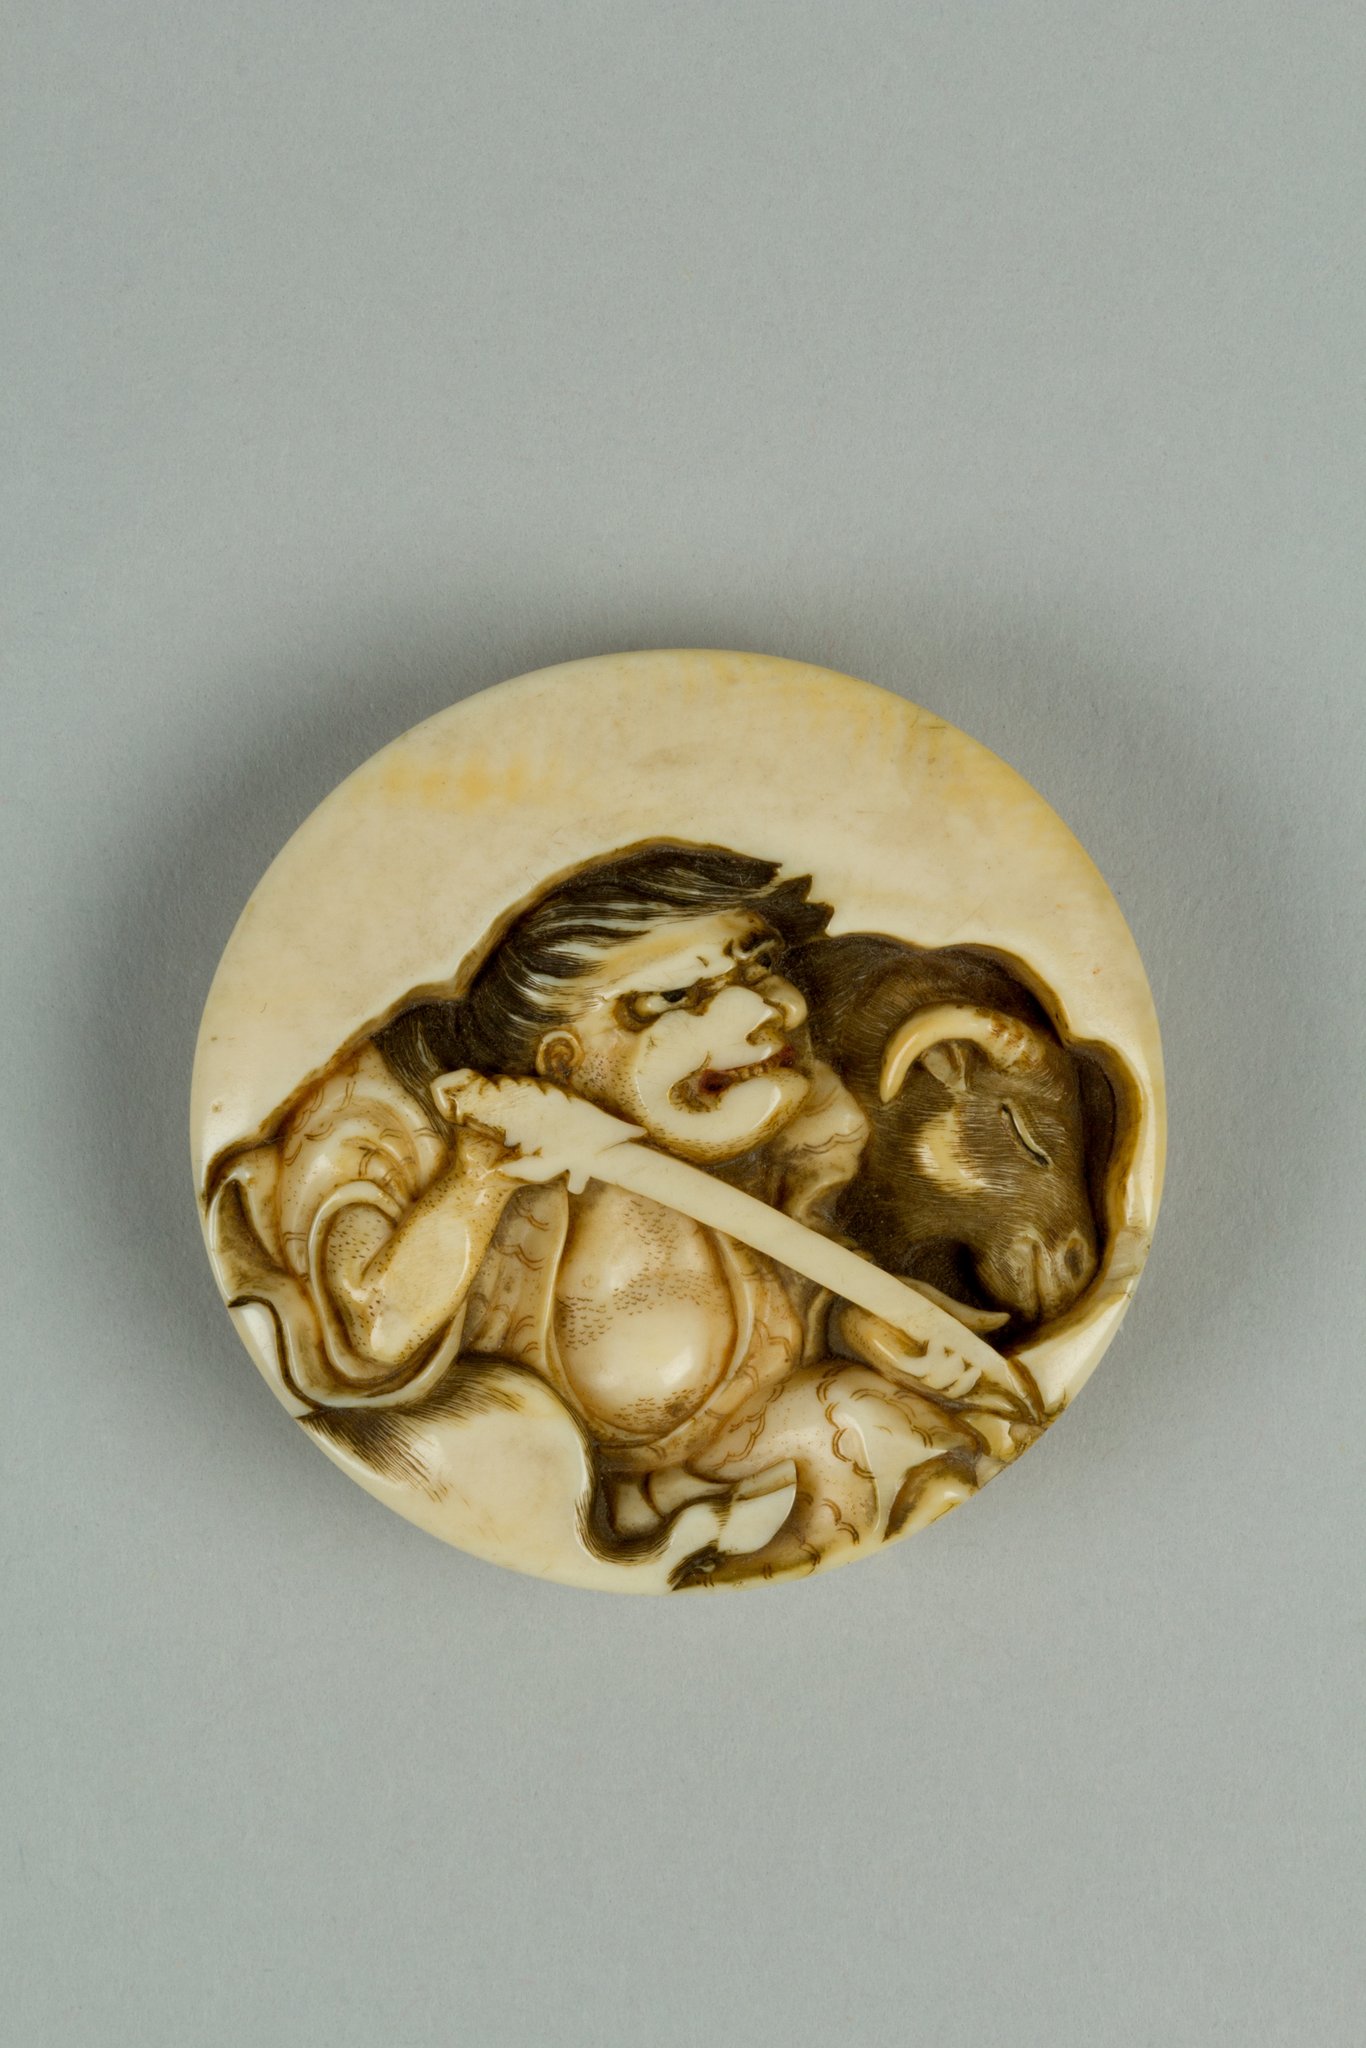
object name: netsuke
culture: japanese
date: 1801-1900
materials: ivory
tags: animals,men